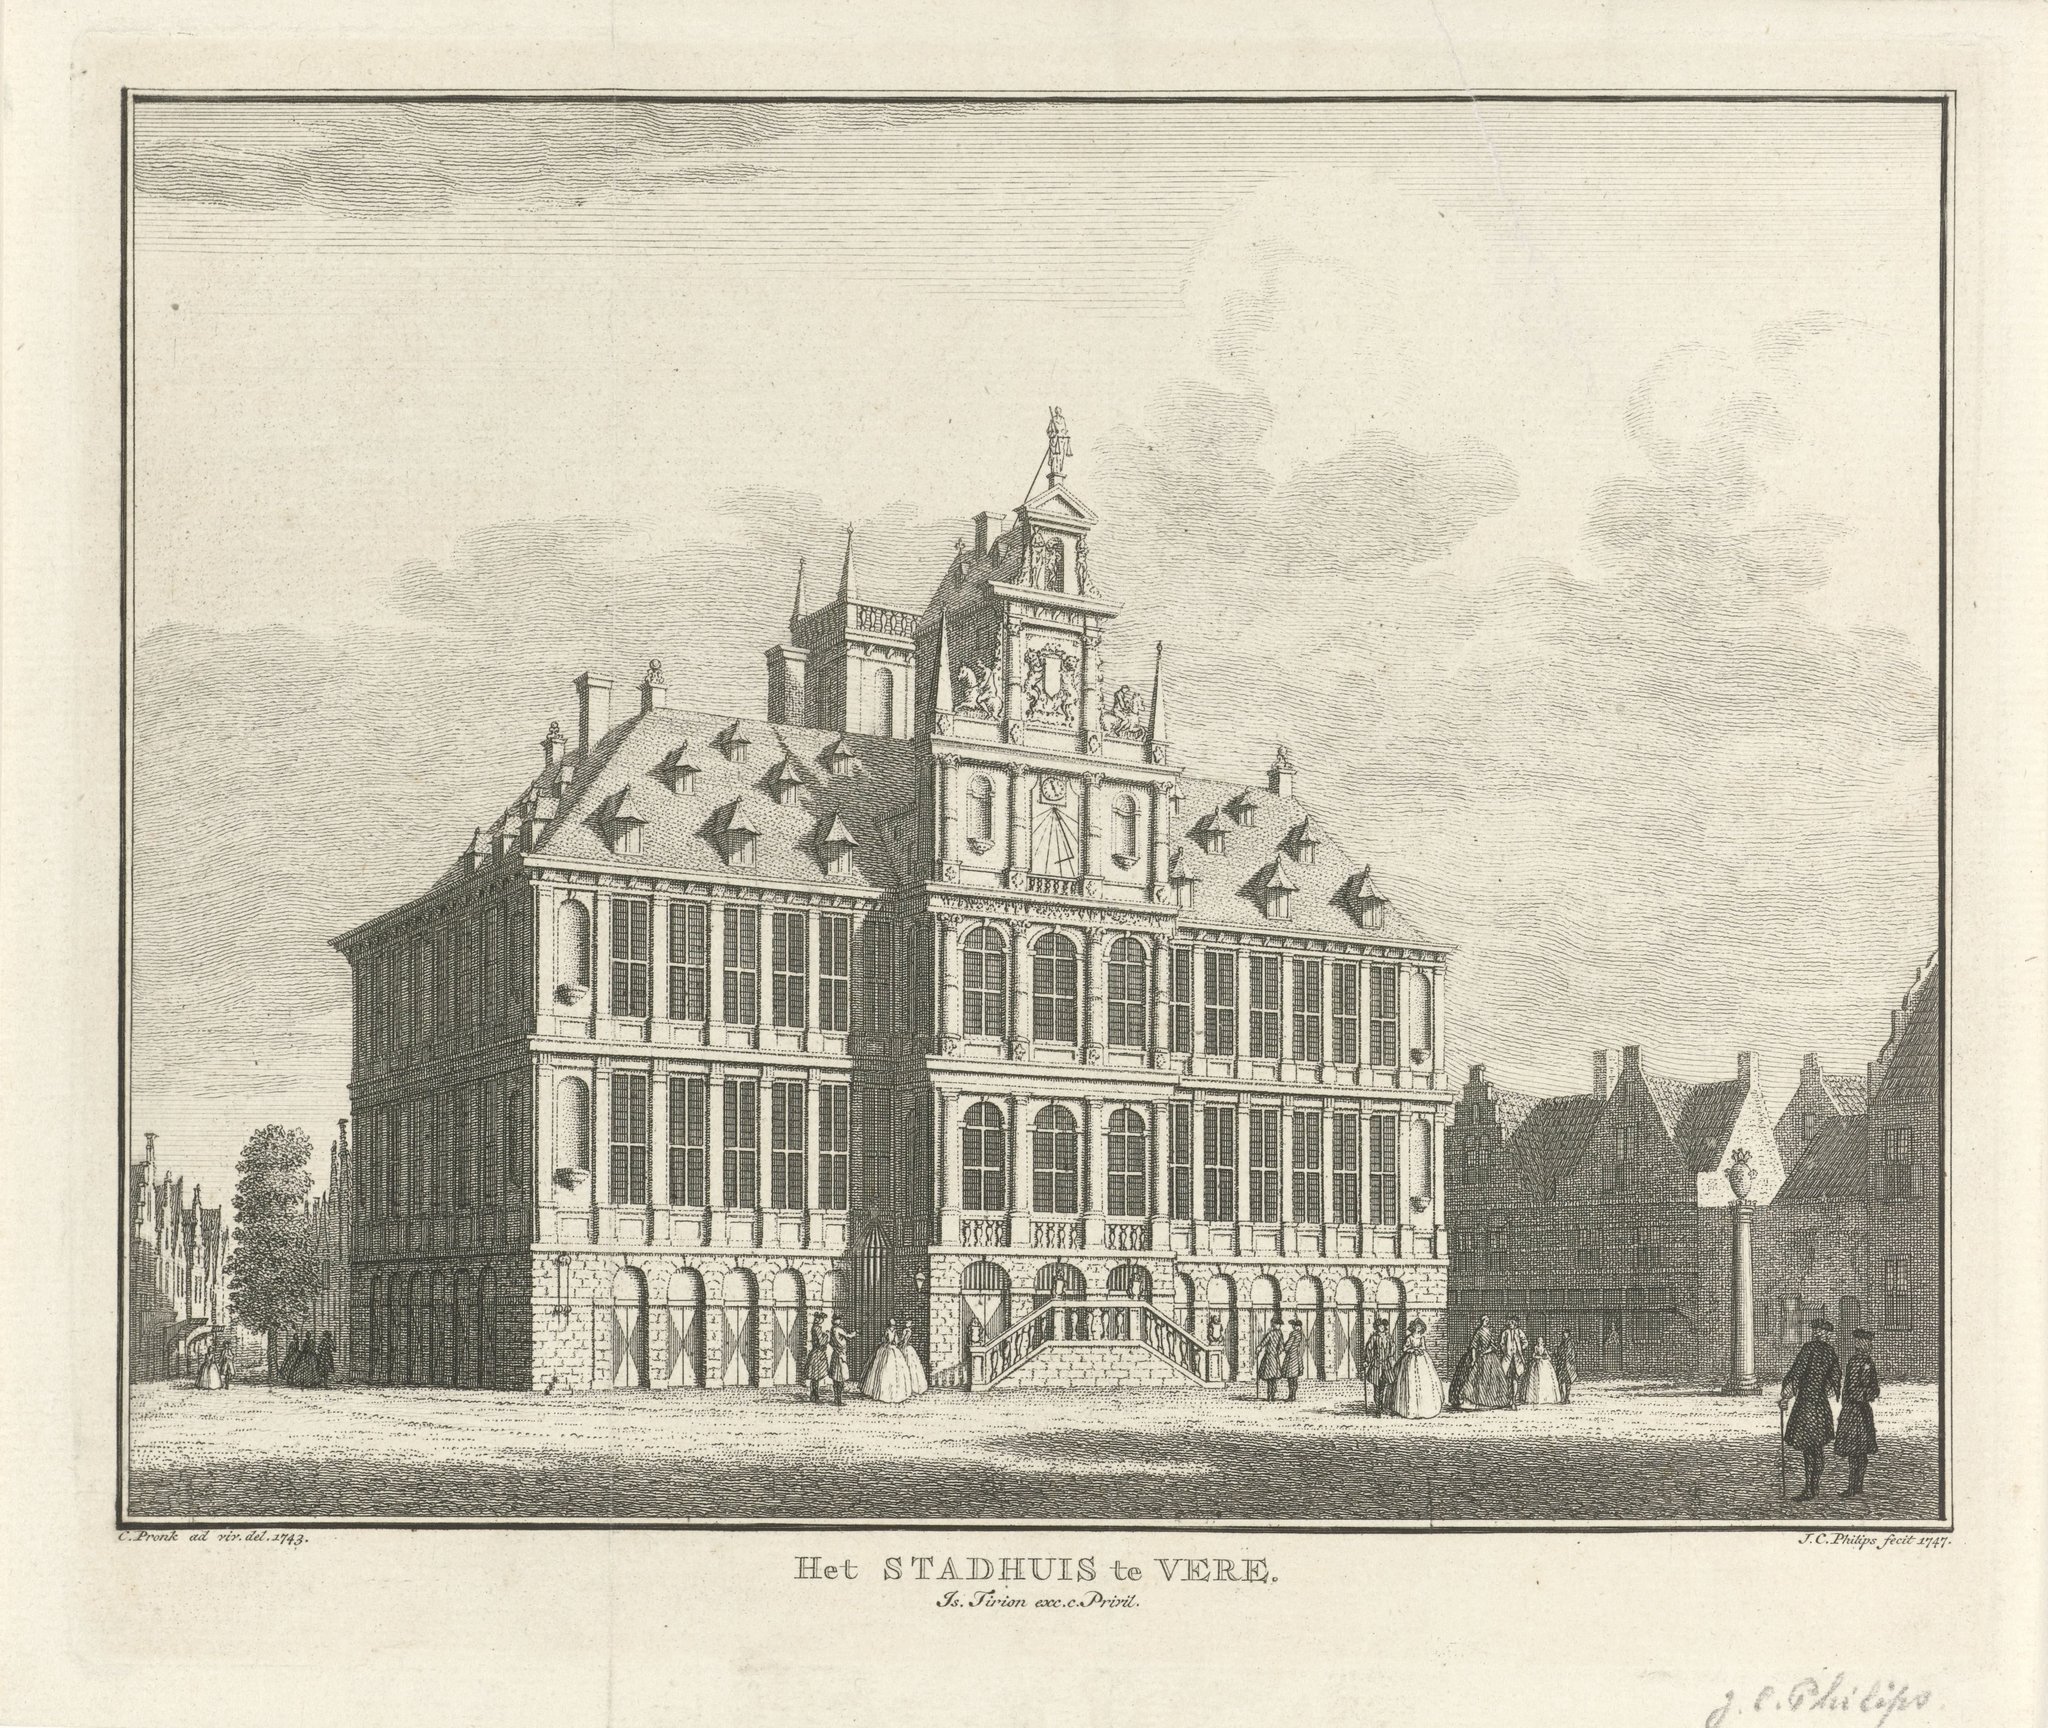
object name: book illustration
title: Het stadhuis te Vere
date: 1747-1760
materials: paper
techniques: etching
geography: amsterdam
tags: townhall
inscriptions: collector's mark: Lugt 2228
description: Gezicht op het Oude Stadhuis van Vlissingen, gelegen aan de Grote Markt, in de situatie omstreeks 1743. Dit stadhuis zou tijdens het bombardement van 1809 worden verwoest. Op de plaat is de verkeerde titel gezet.